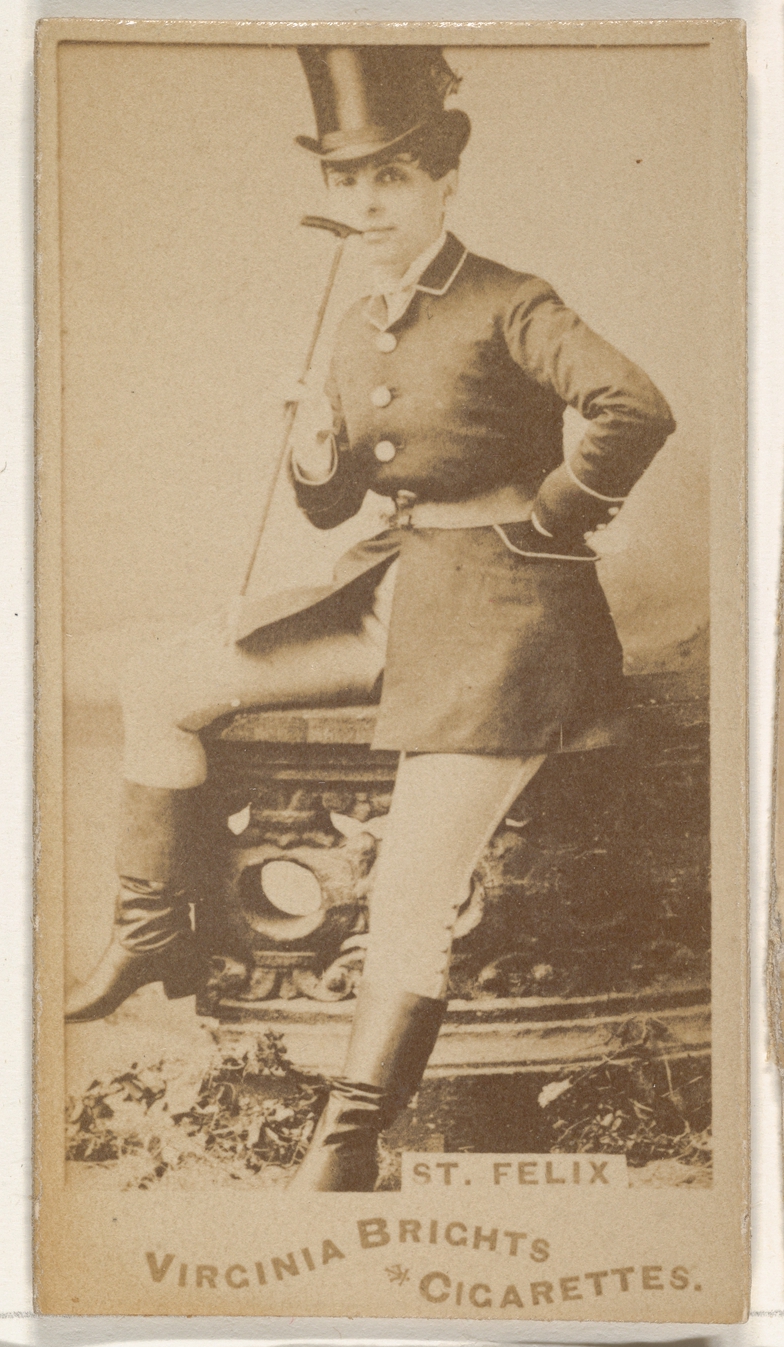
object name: photograph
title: St. Felix, from the Actors and Actresses series (N45, Type 1) for Virginia Brights Cigarettes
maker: allen & ginter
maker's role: publisher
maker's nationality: american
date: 1888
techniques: albumen silver print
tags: portraits,actors